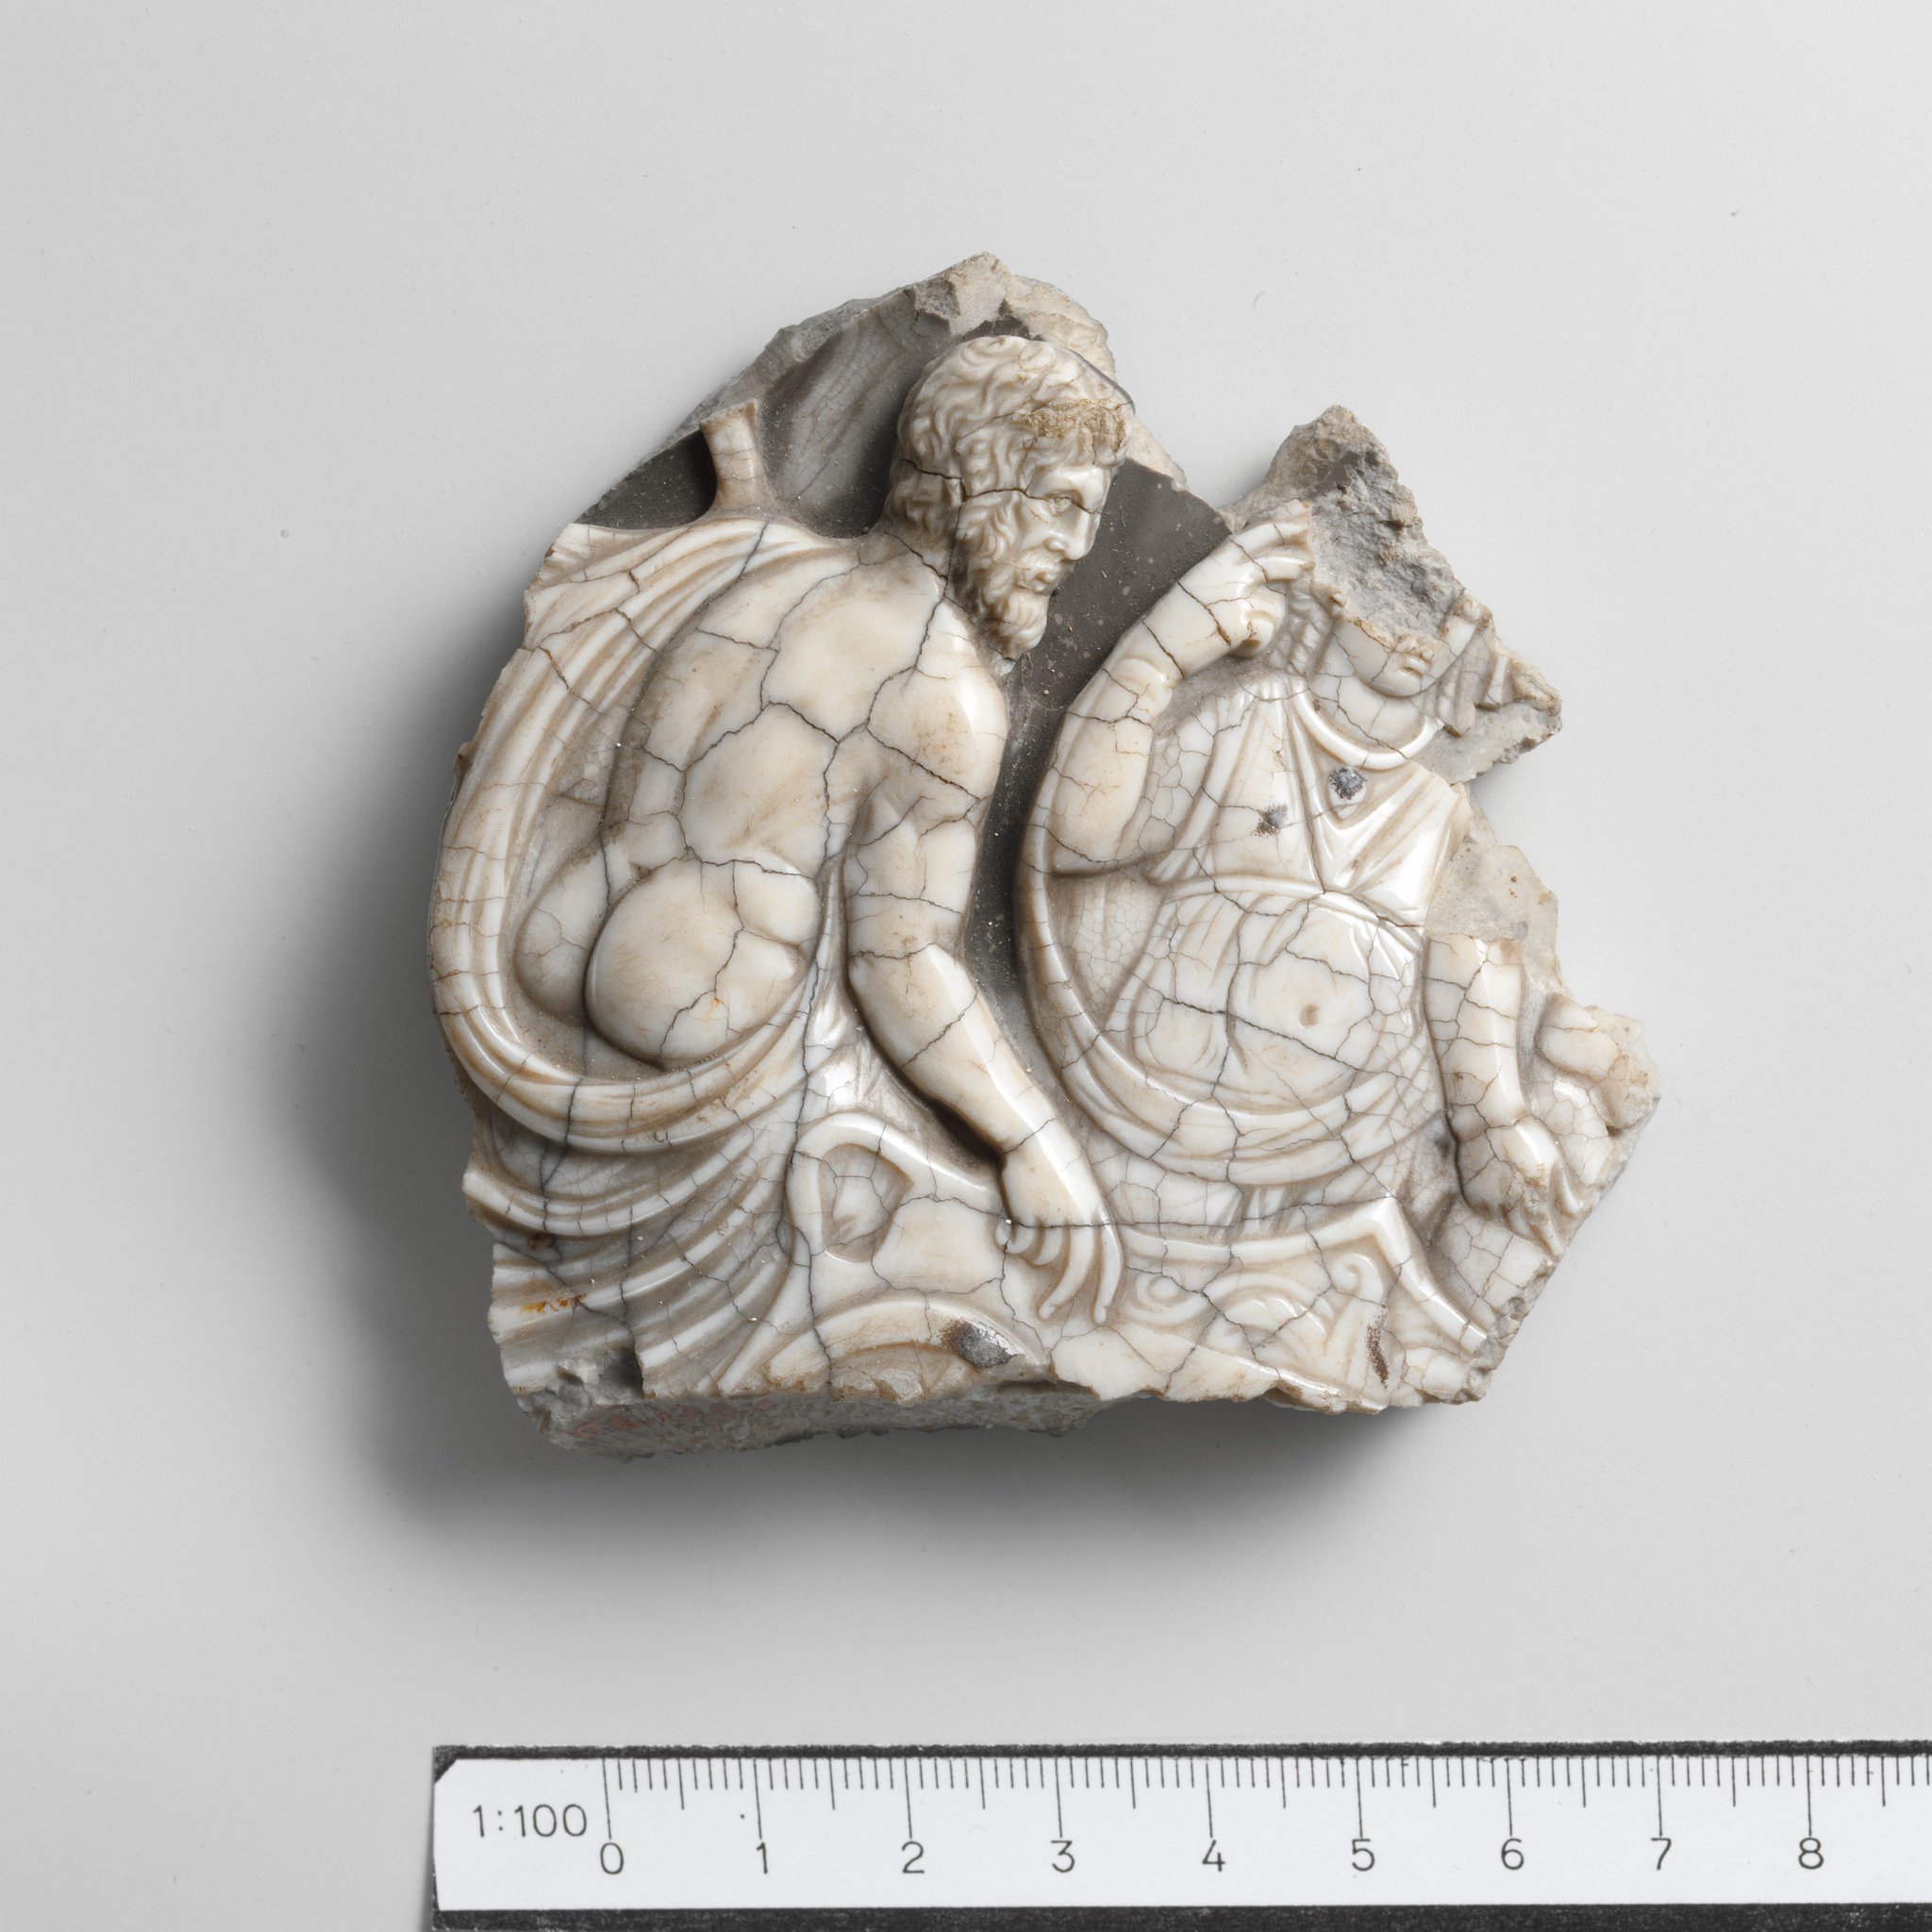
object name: cameo, fragment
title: Onyx cameo fragment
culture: roman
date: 34 BCE-100 CE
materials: onyx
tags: men,women